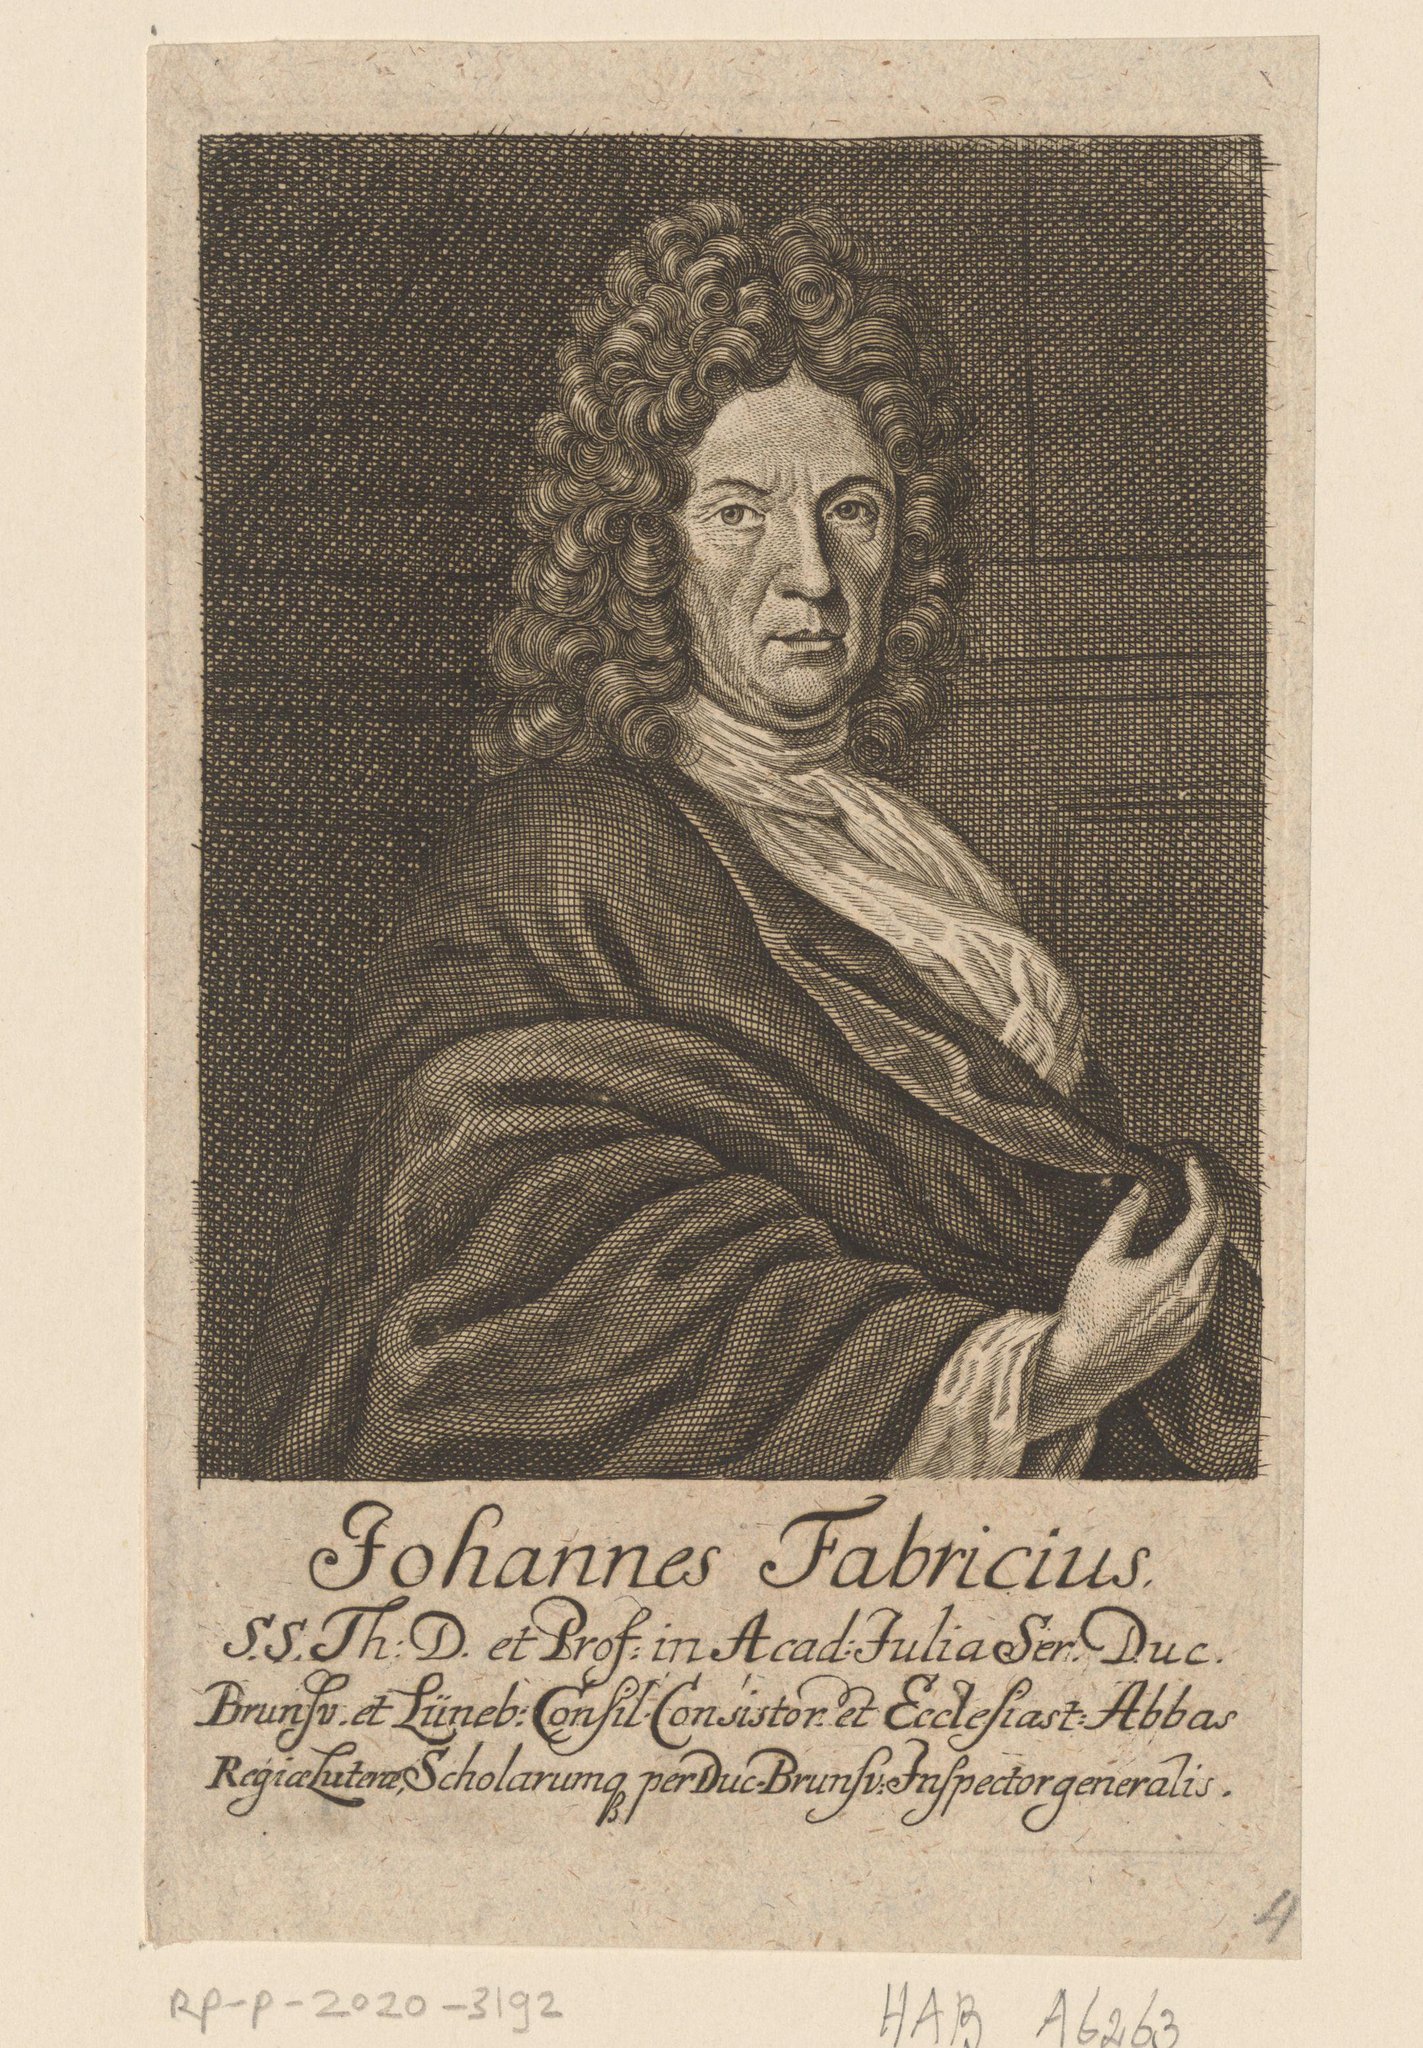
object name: print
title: Portret van Johann Fabricius IV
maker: Anonymous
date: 1680-1730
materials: paper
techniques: engraving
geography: germany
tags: theologian, historical persons